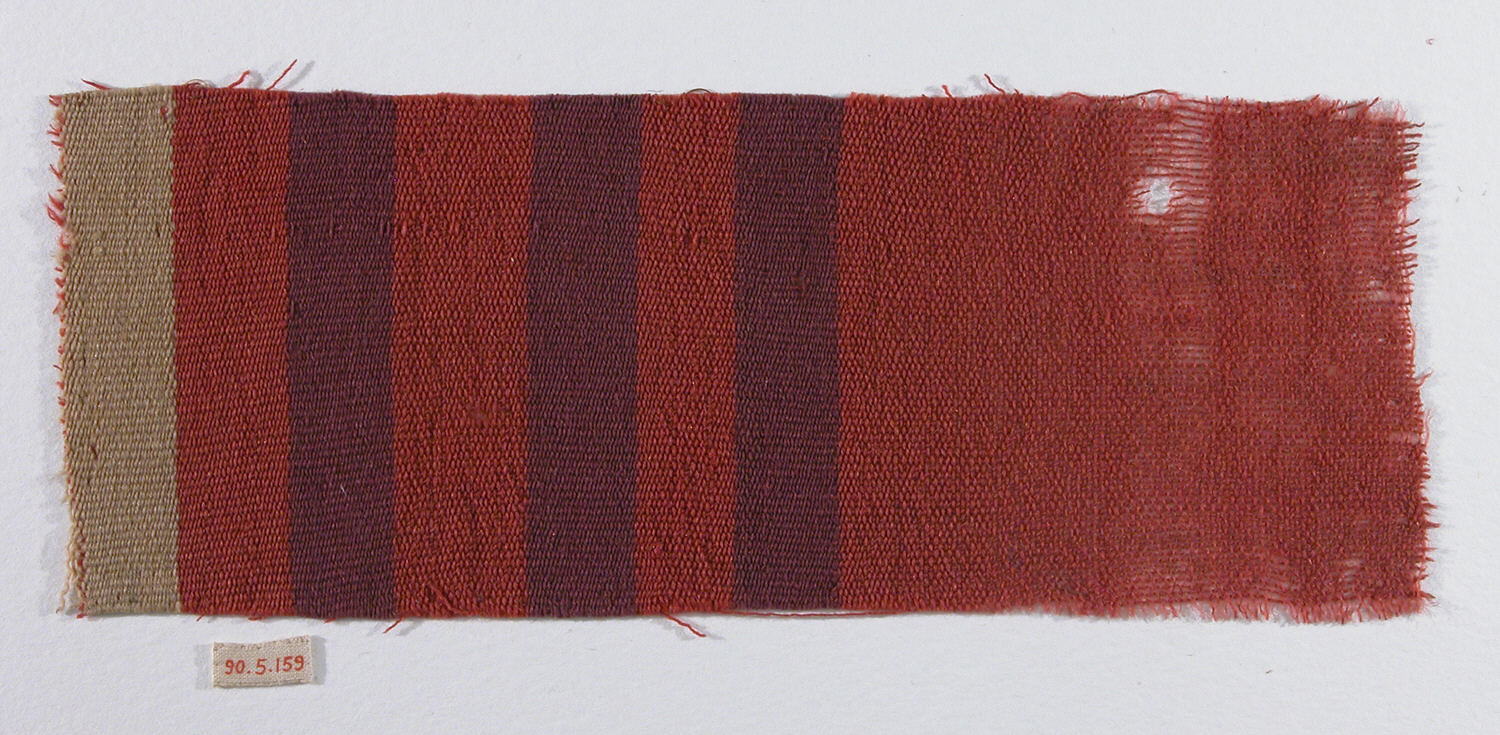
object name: textile fragment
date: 301-500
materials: wool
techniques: weave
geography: egypt